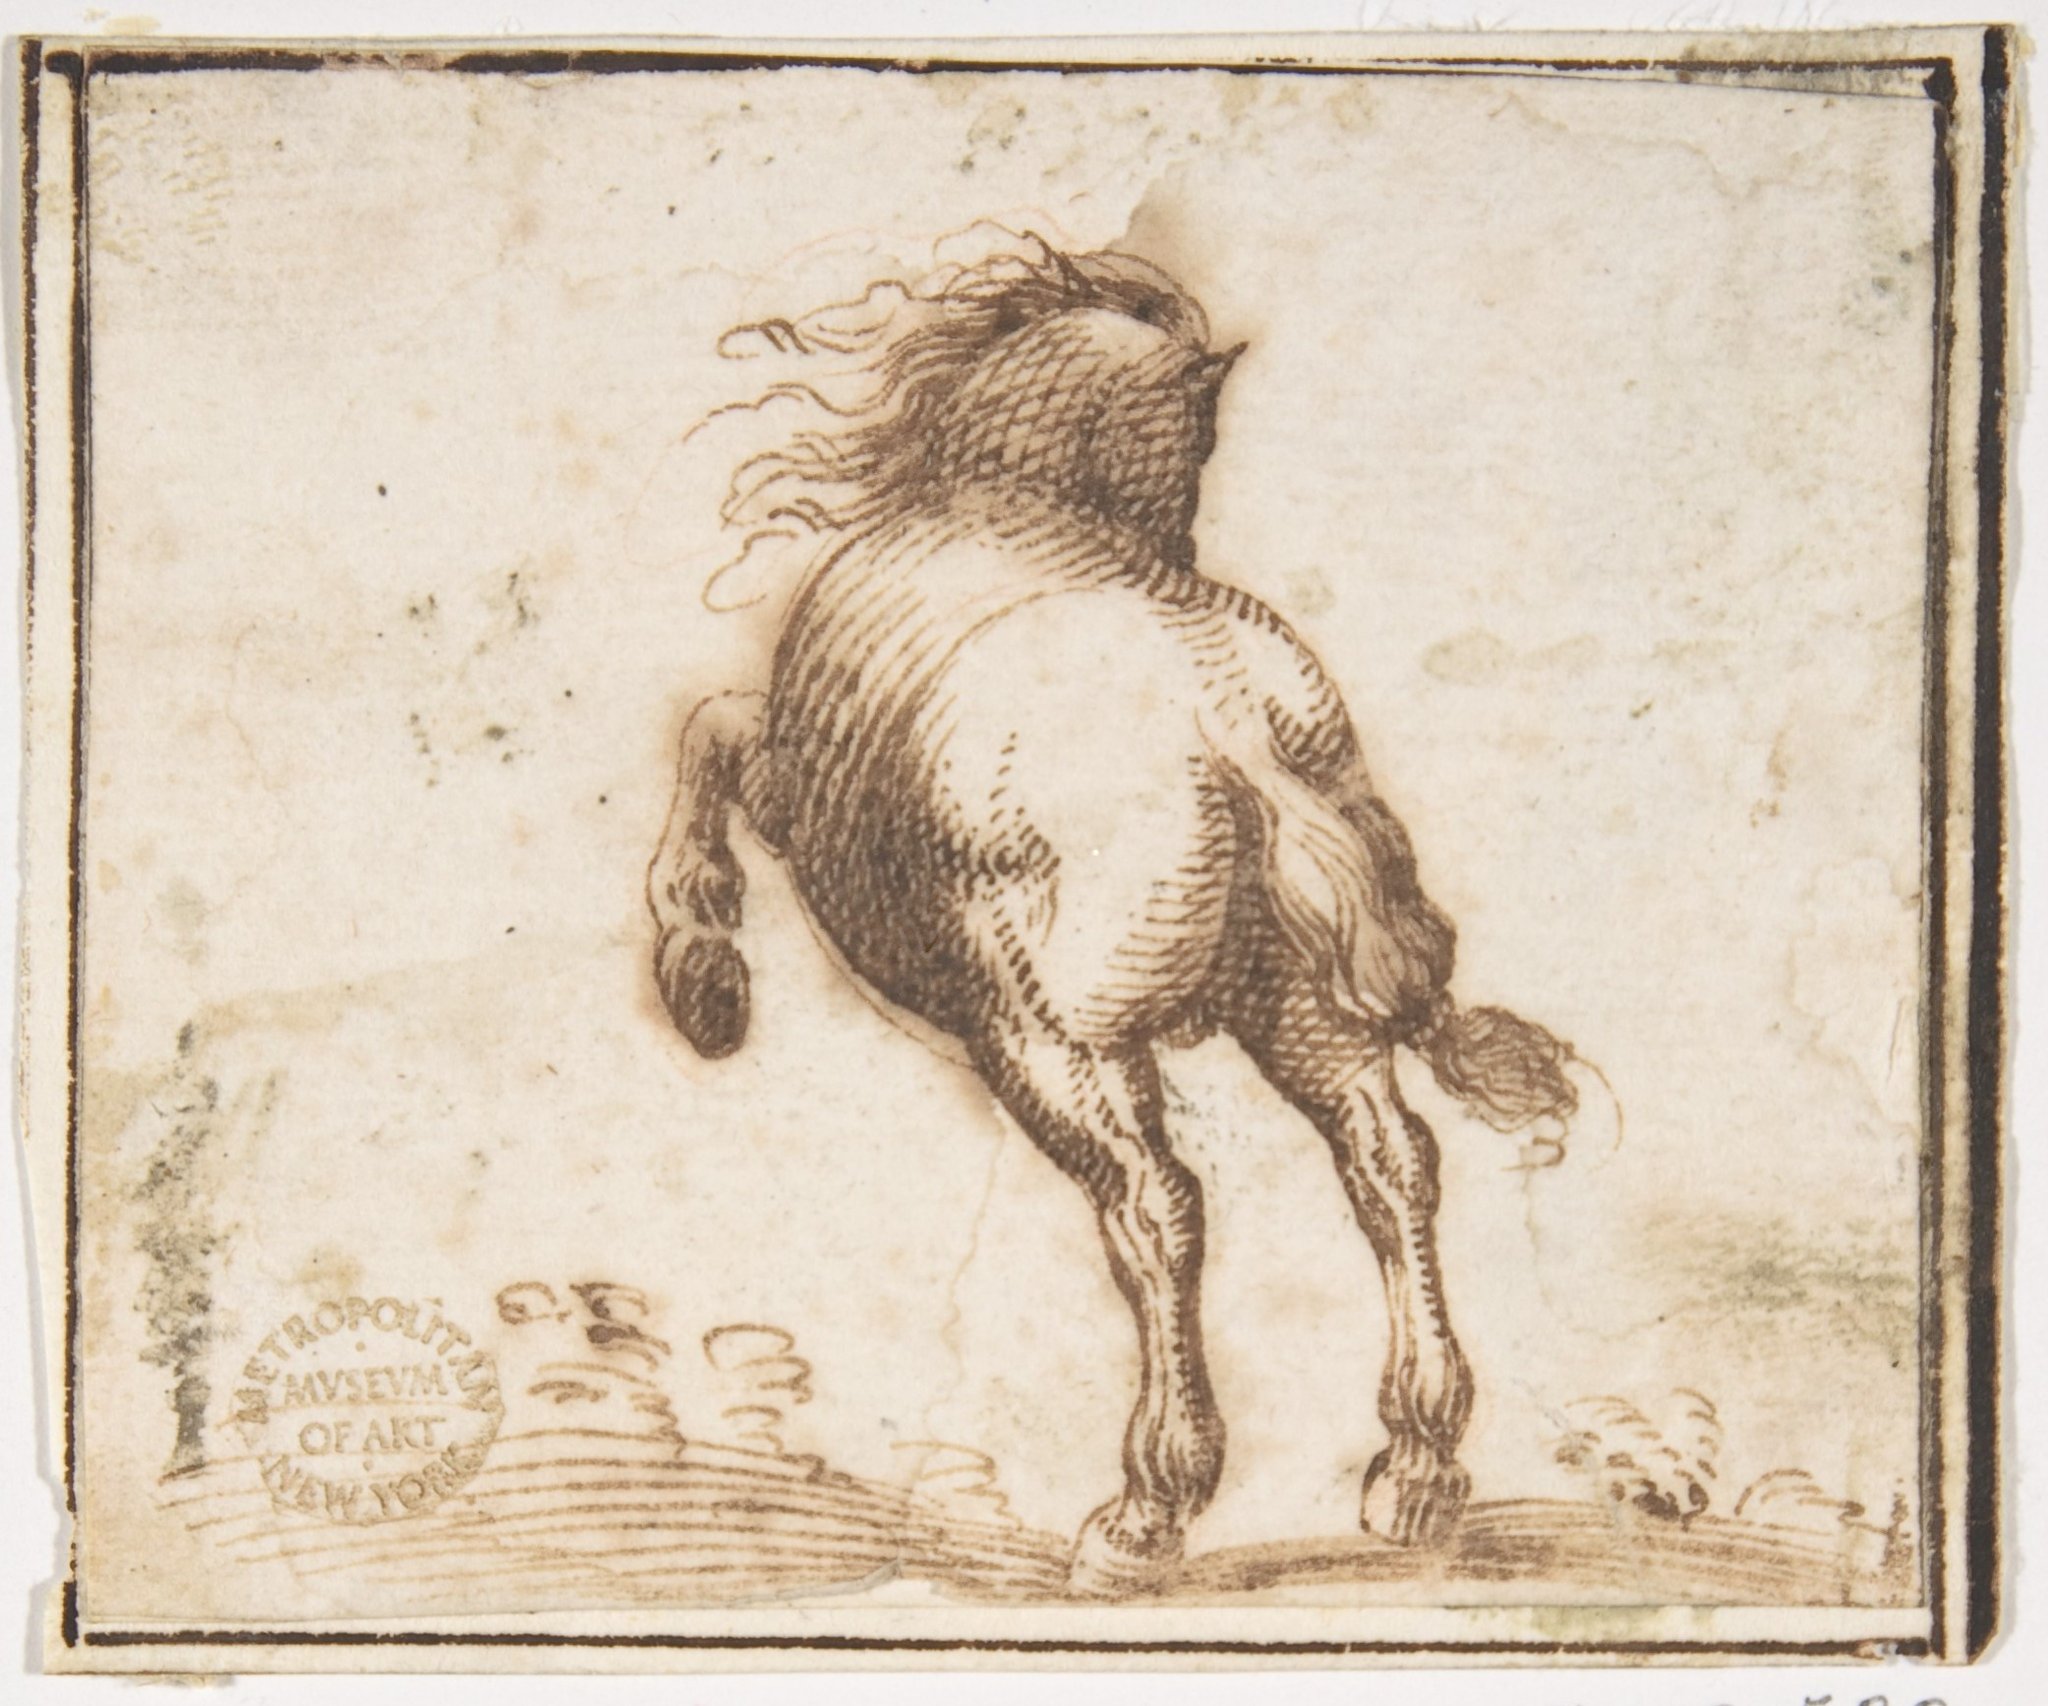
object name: drawing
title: Horse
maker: francesco allegrini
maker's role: artist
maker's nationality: italian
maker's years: 1615-1679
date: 1624-1663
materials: ink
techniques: pen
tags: horses